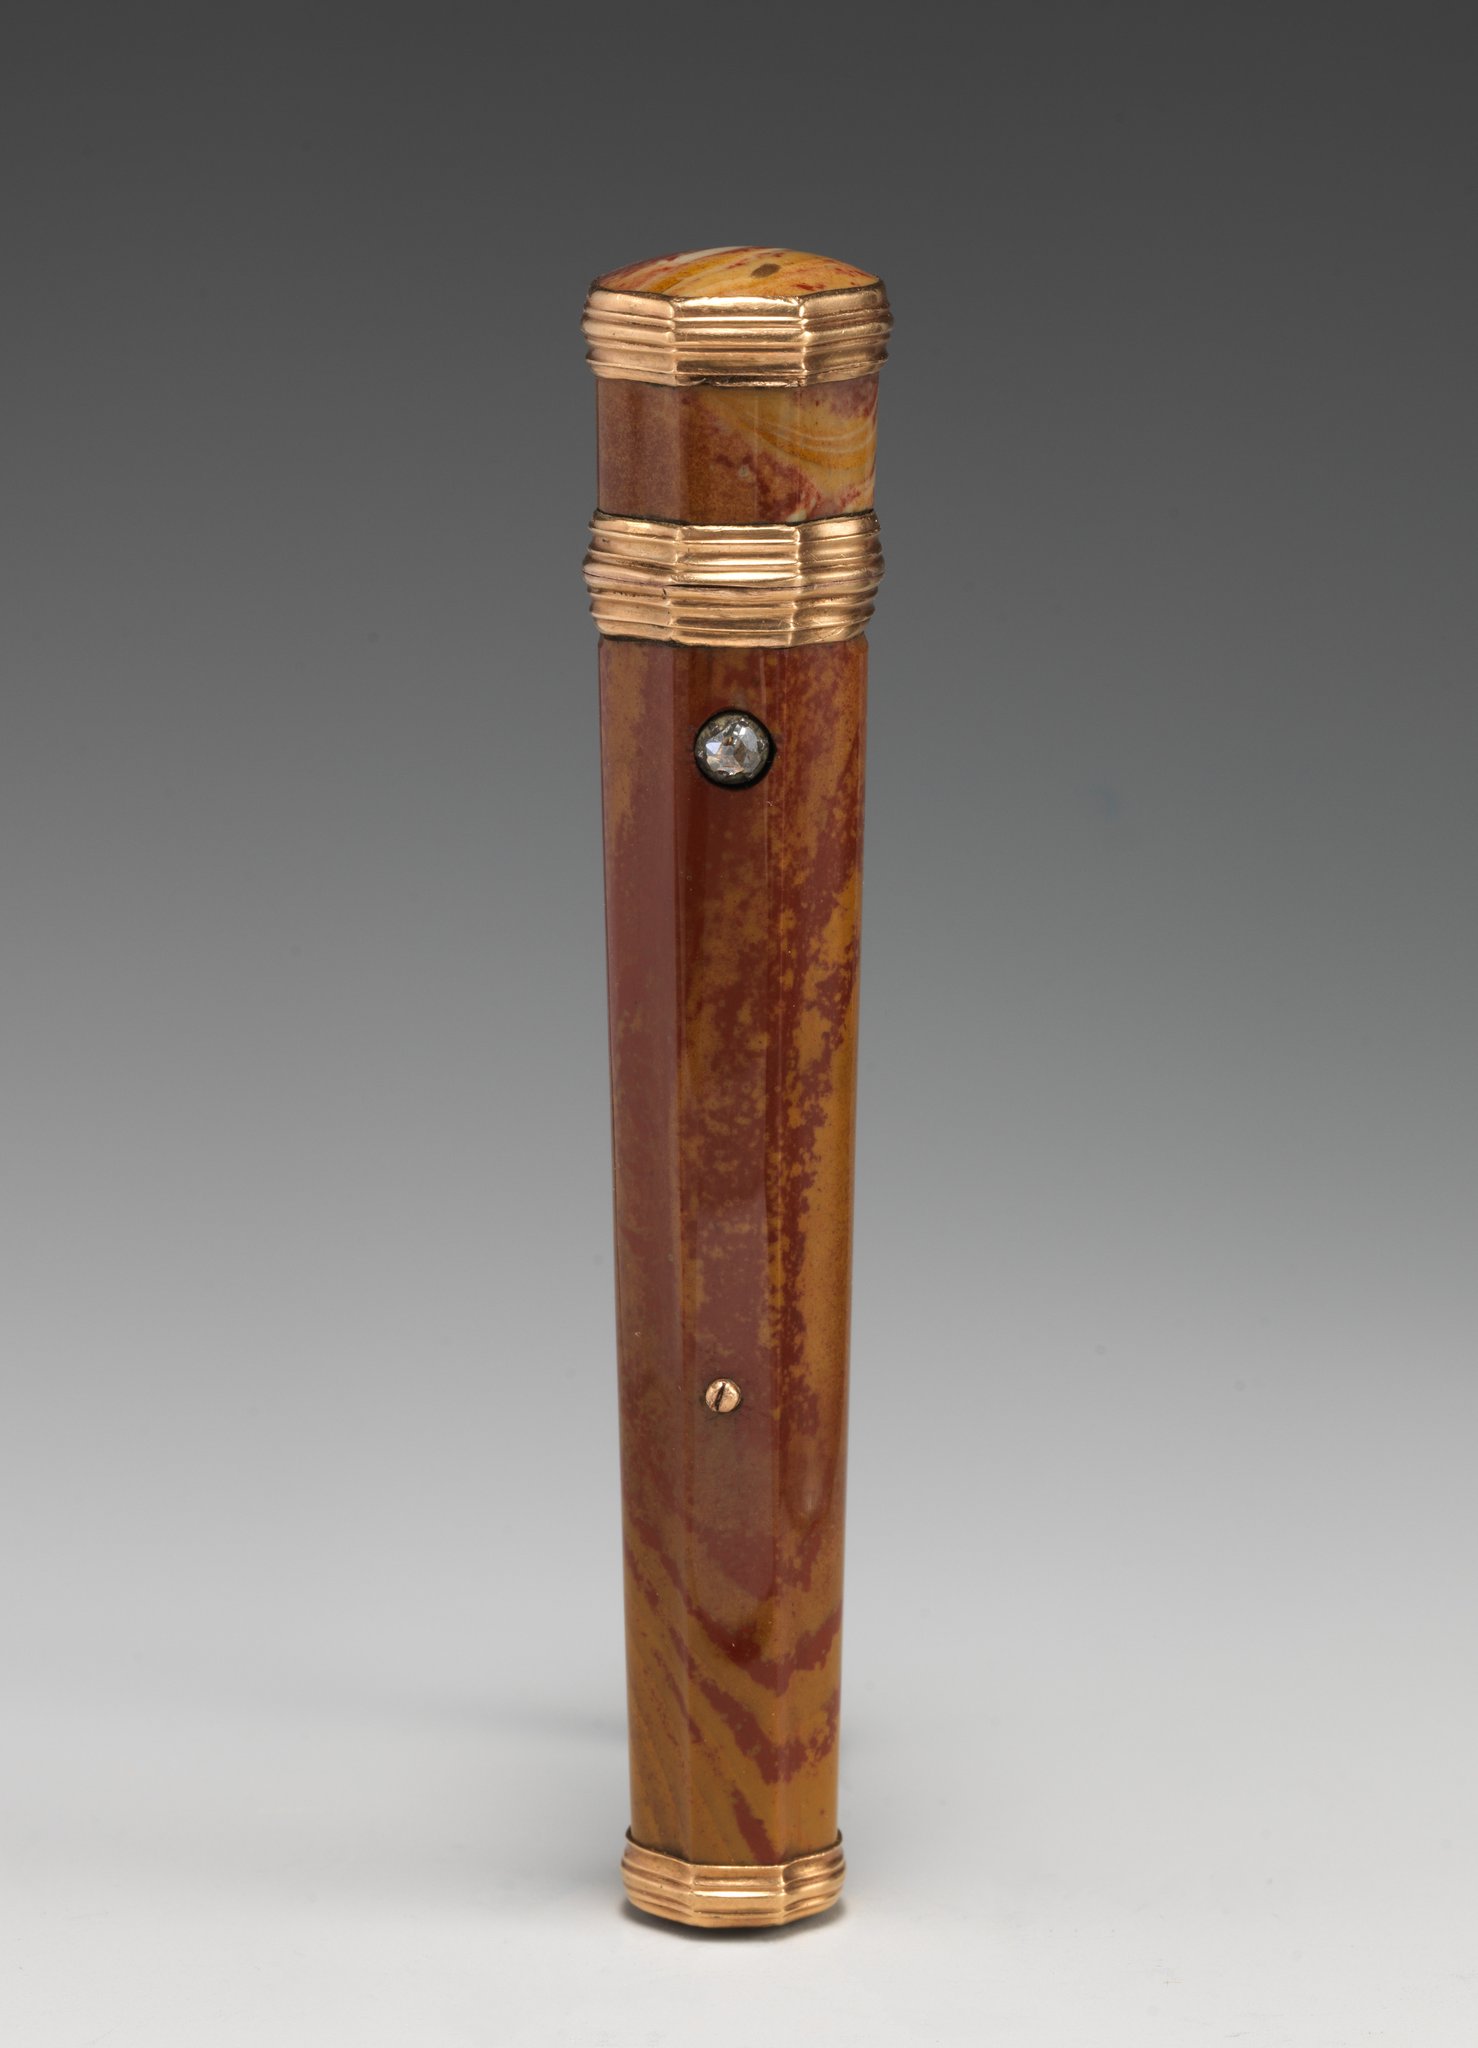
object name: étui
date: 1750-1770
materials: stone, gold